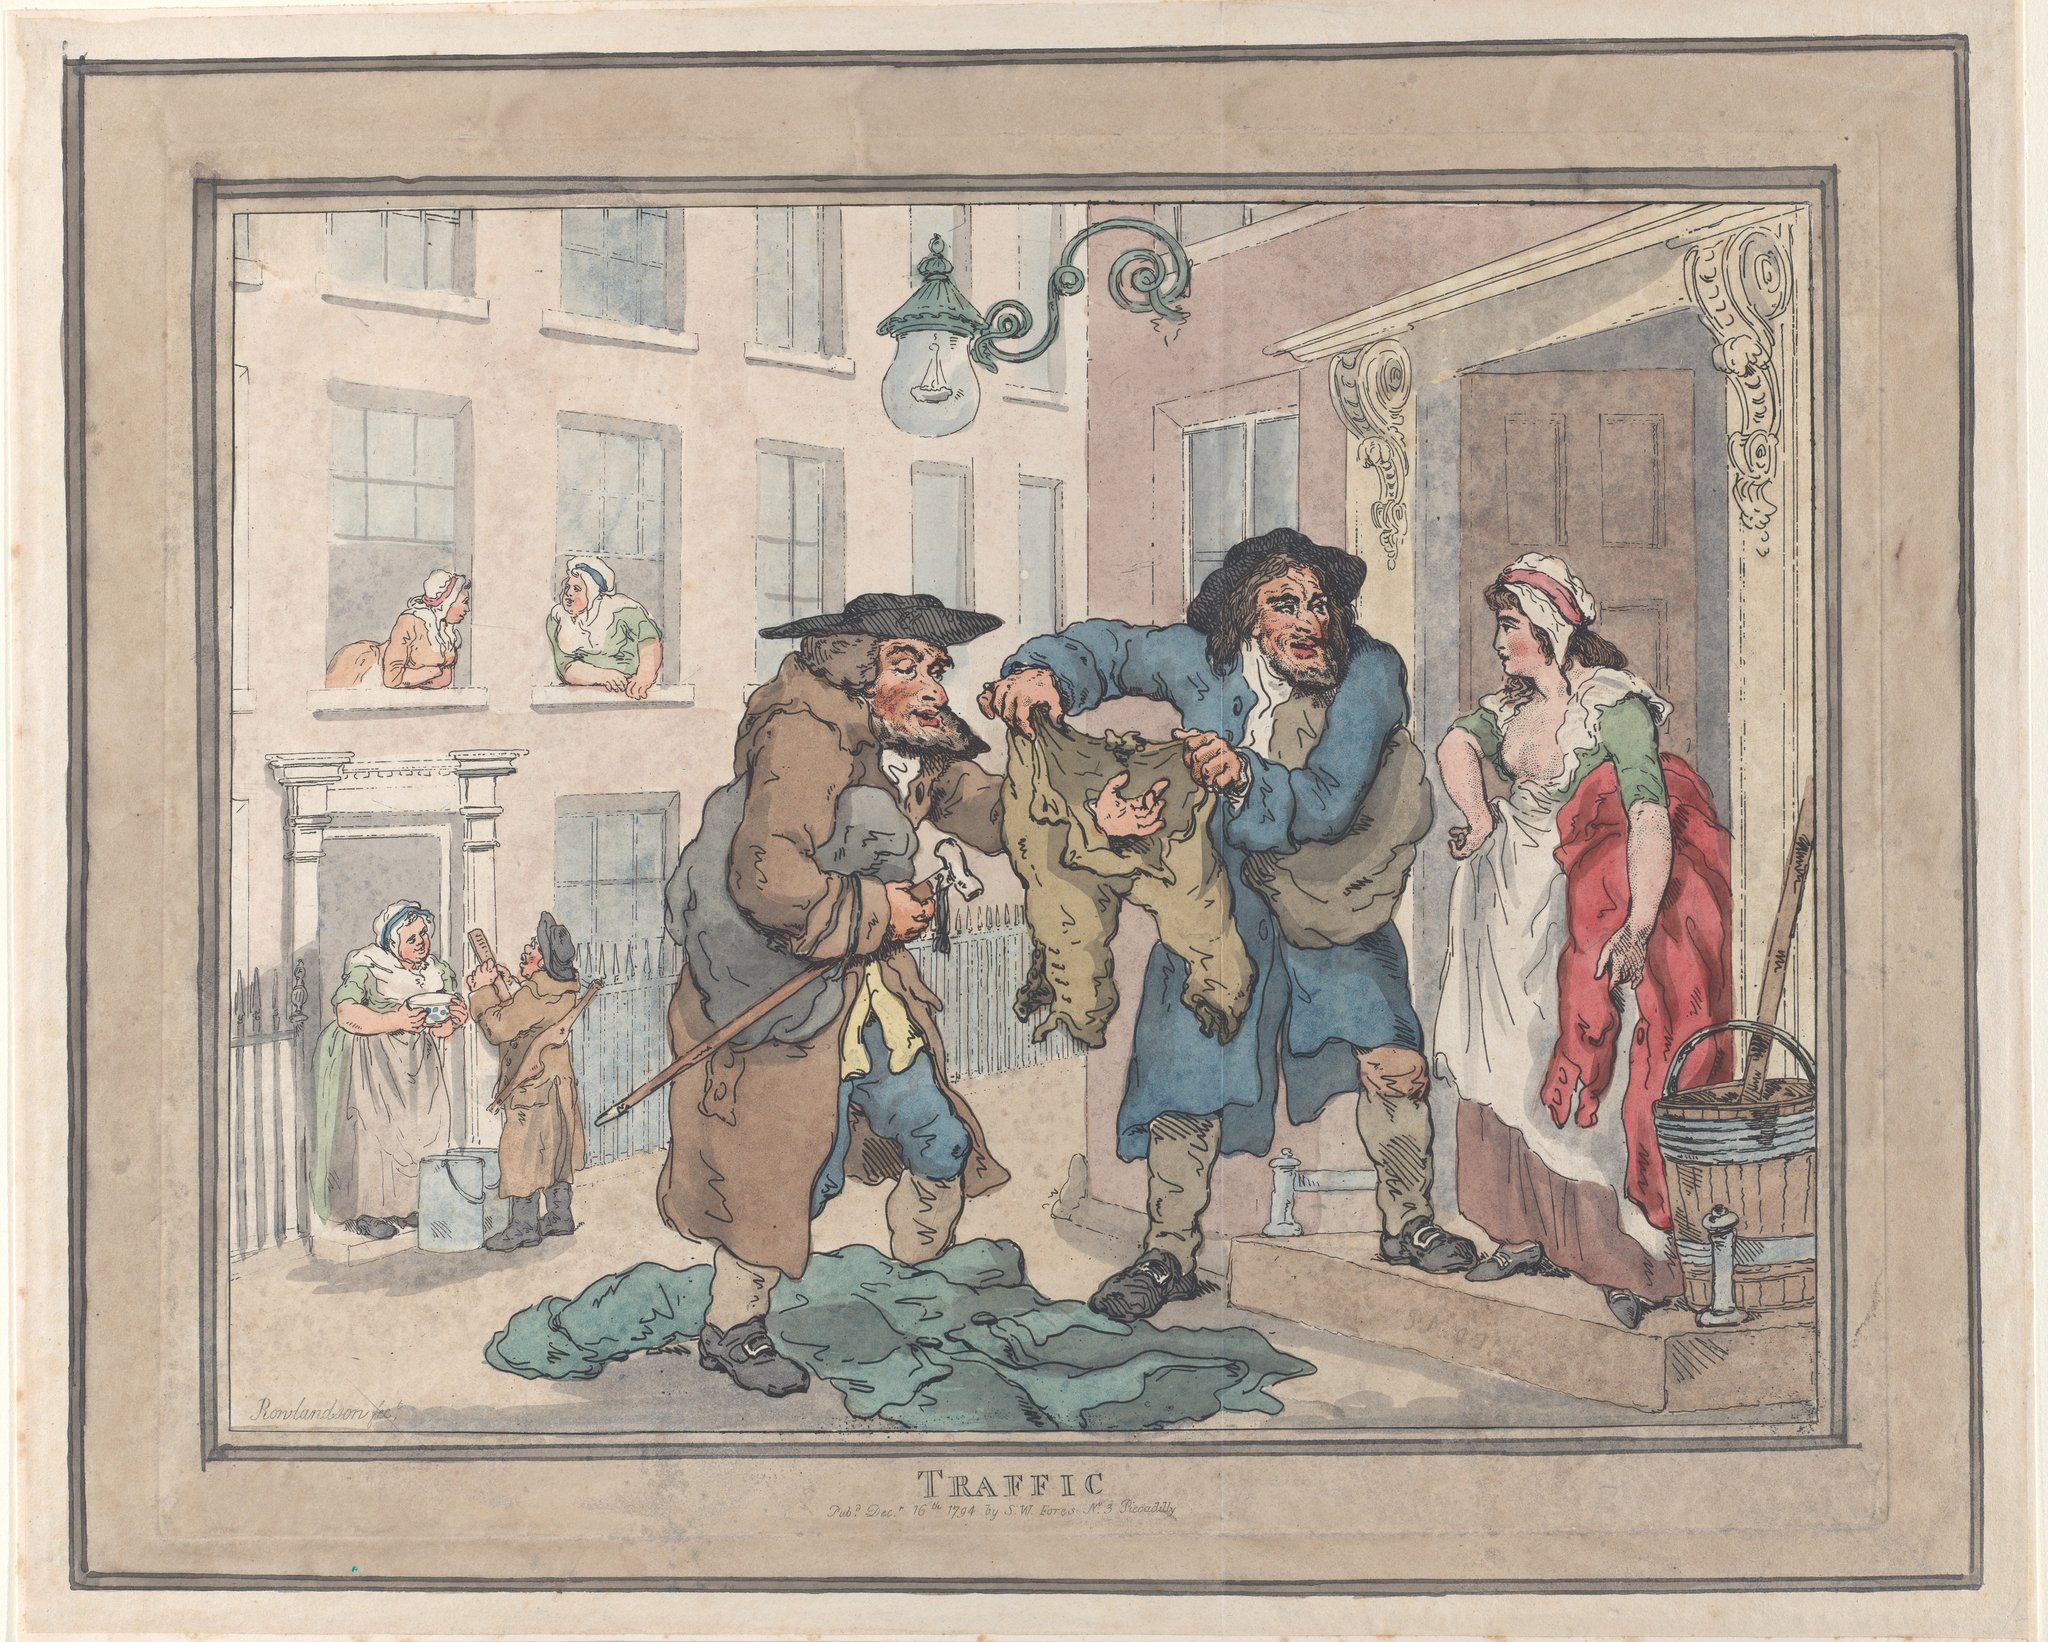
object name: print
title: Traffic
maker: thomas rowlandson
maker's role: artist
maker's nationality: british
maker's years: 1757-1827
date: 1791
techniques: aquatint, etching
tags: satire,men,women,servants